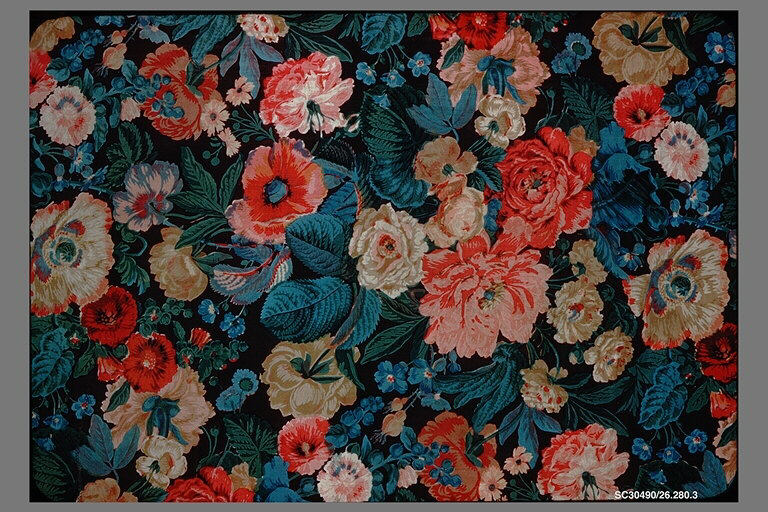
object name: piece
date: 1848-1851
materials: cotton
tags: flowers,leaves